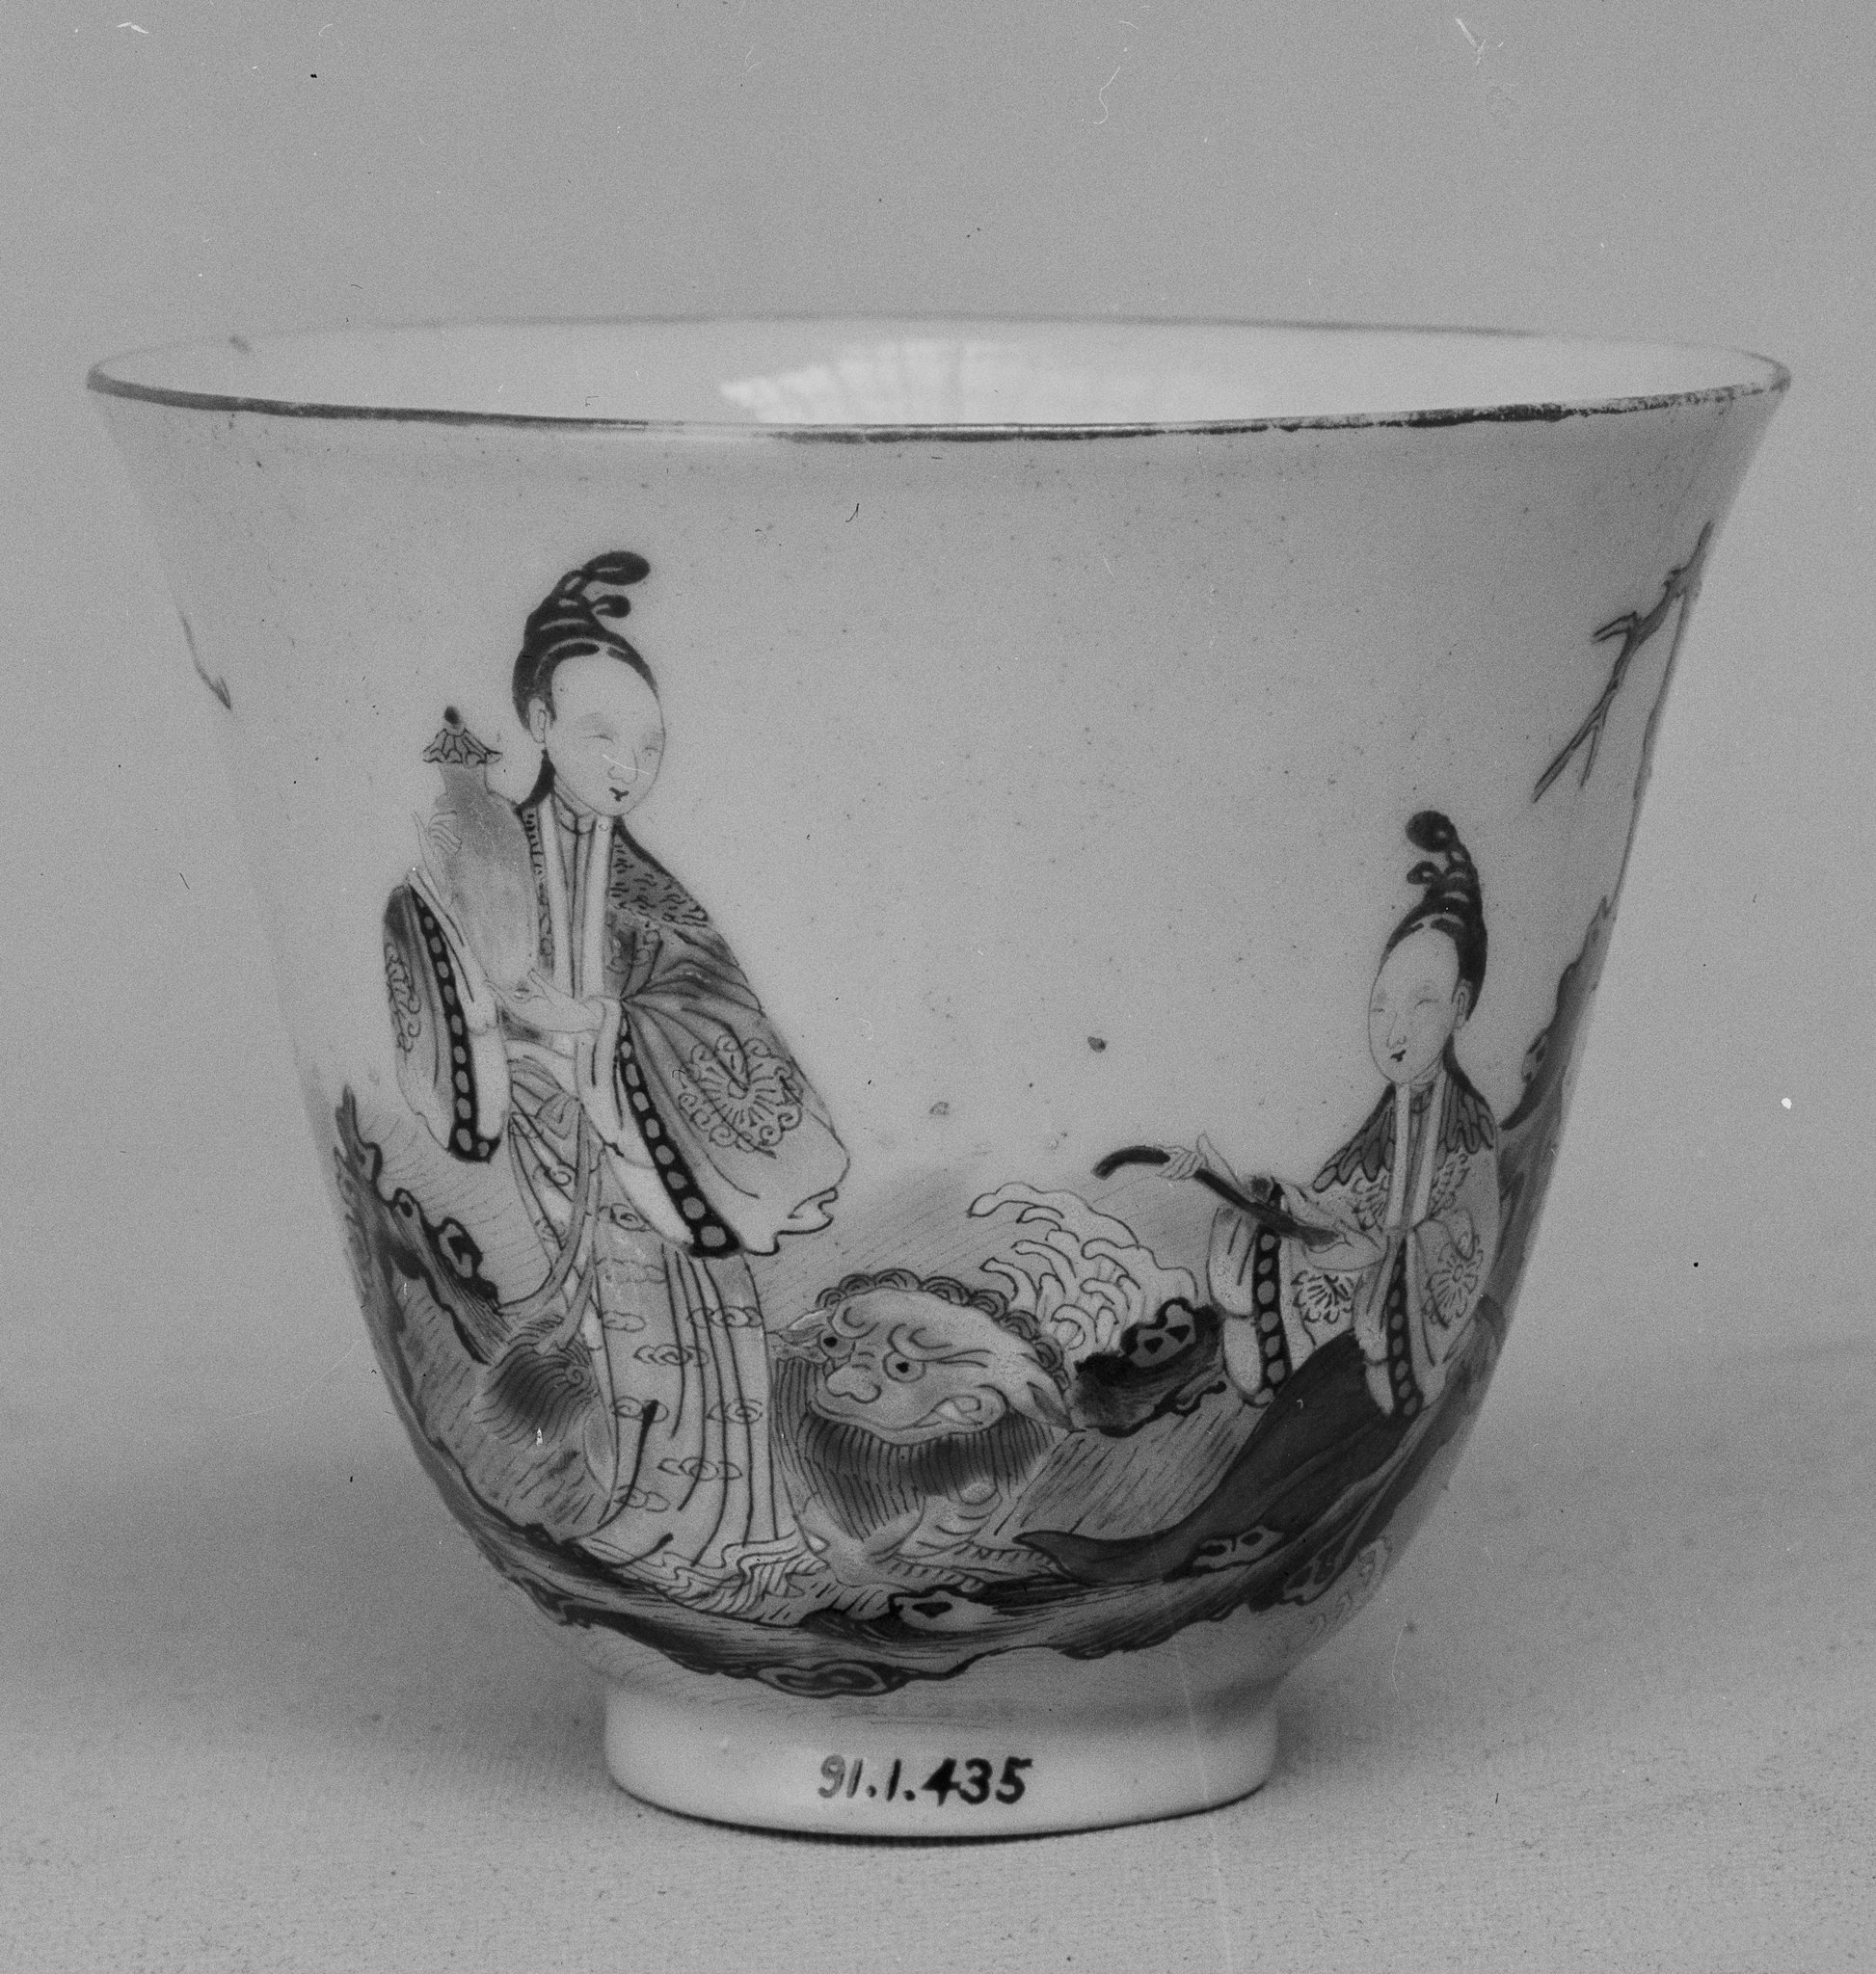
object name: cup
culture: chinese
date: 1796-1820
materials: enamel, porcelain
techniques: overglaze, painting, polychrome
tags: women,lions